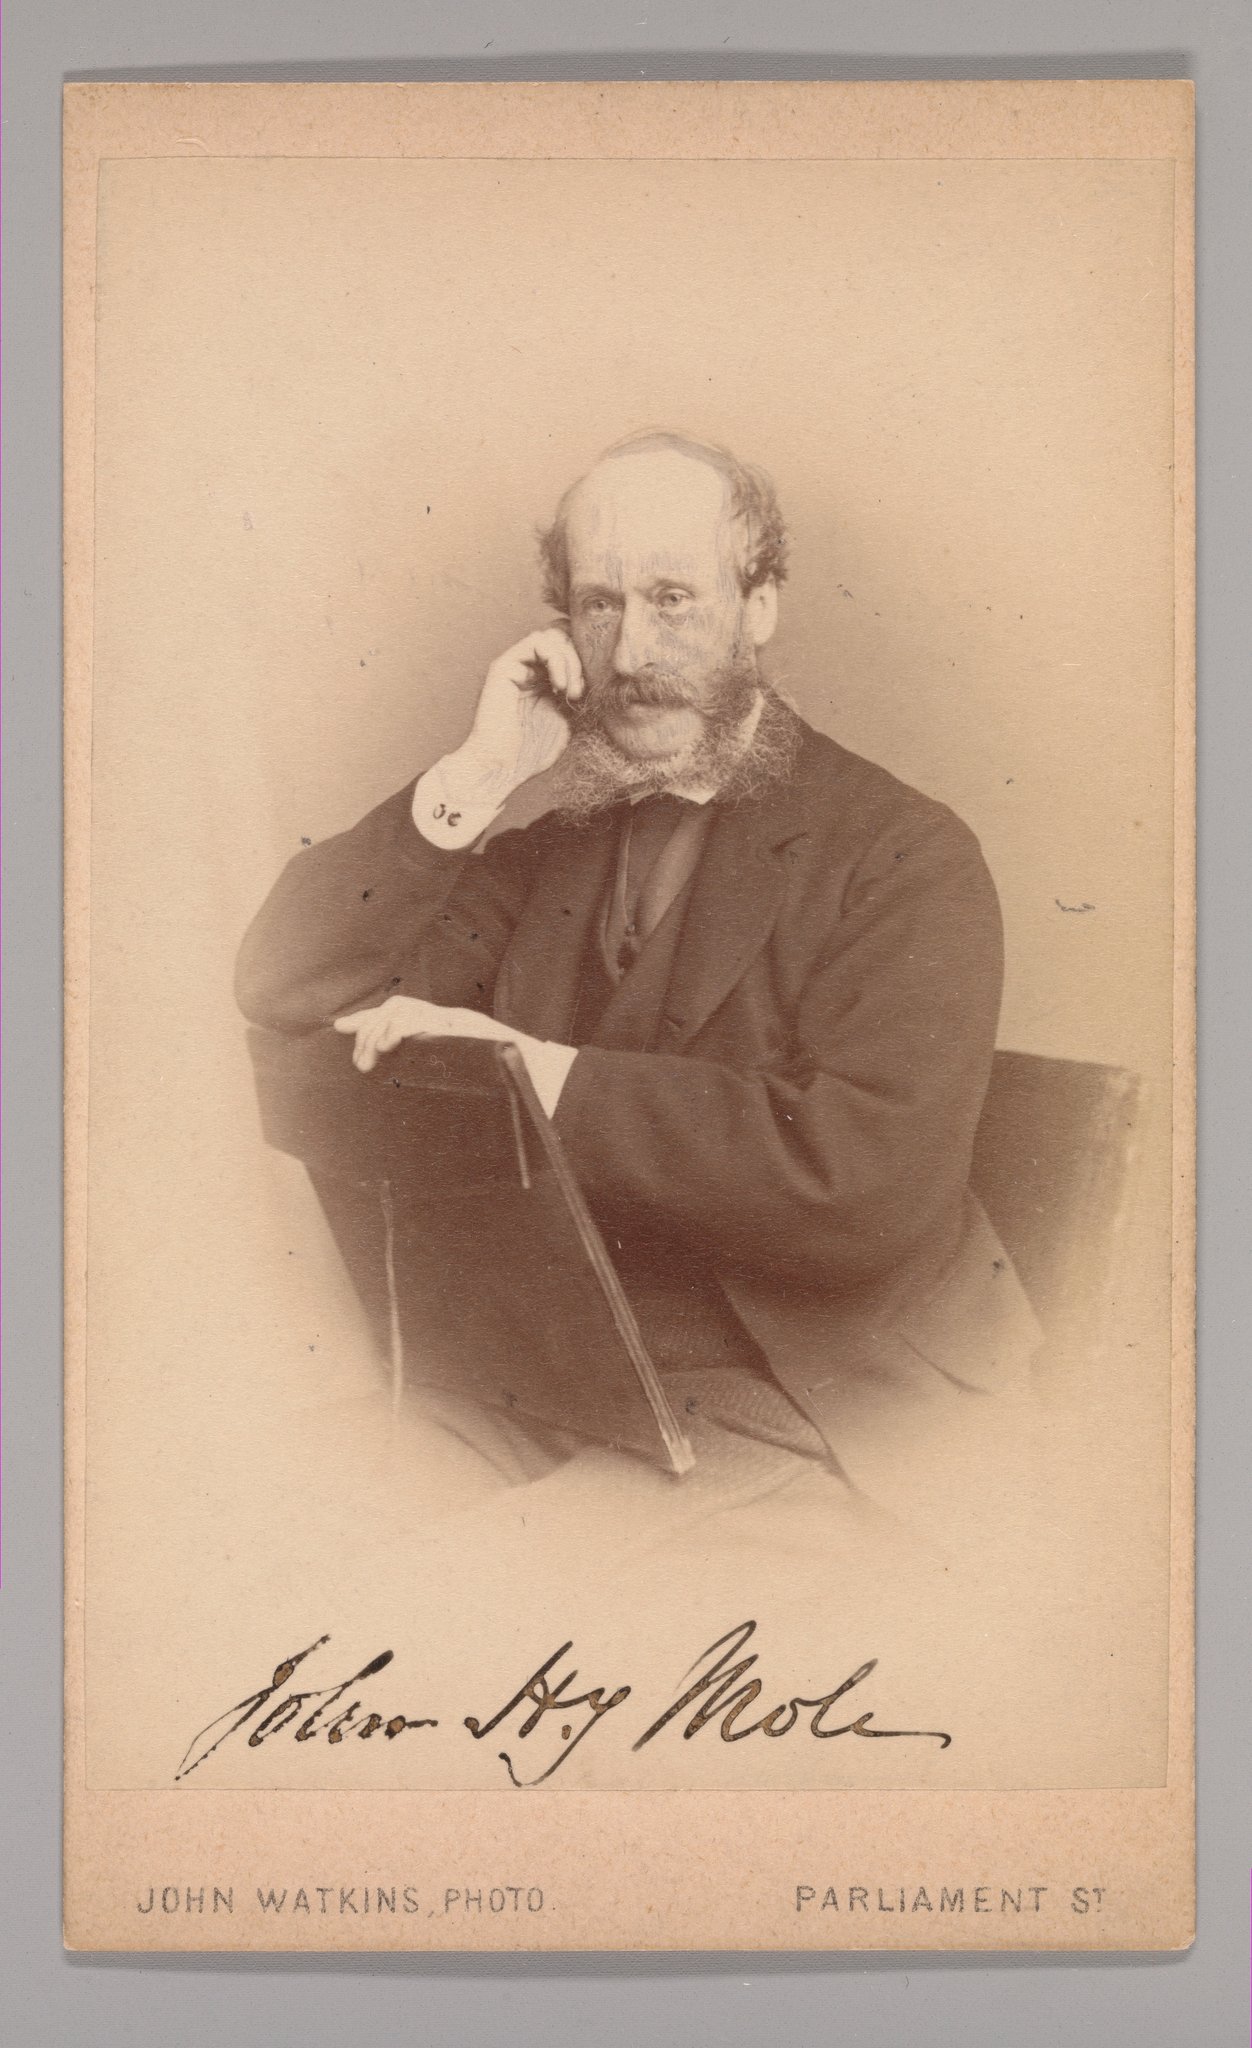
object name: carte de visite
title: [John Henry Mole]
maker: john and charles watkins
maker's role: photography studio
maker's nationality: british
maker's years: 1840-1875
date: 1860-1869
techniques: albumen silver print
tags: men,portraits,artists